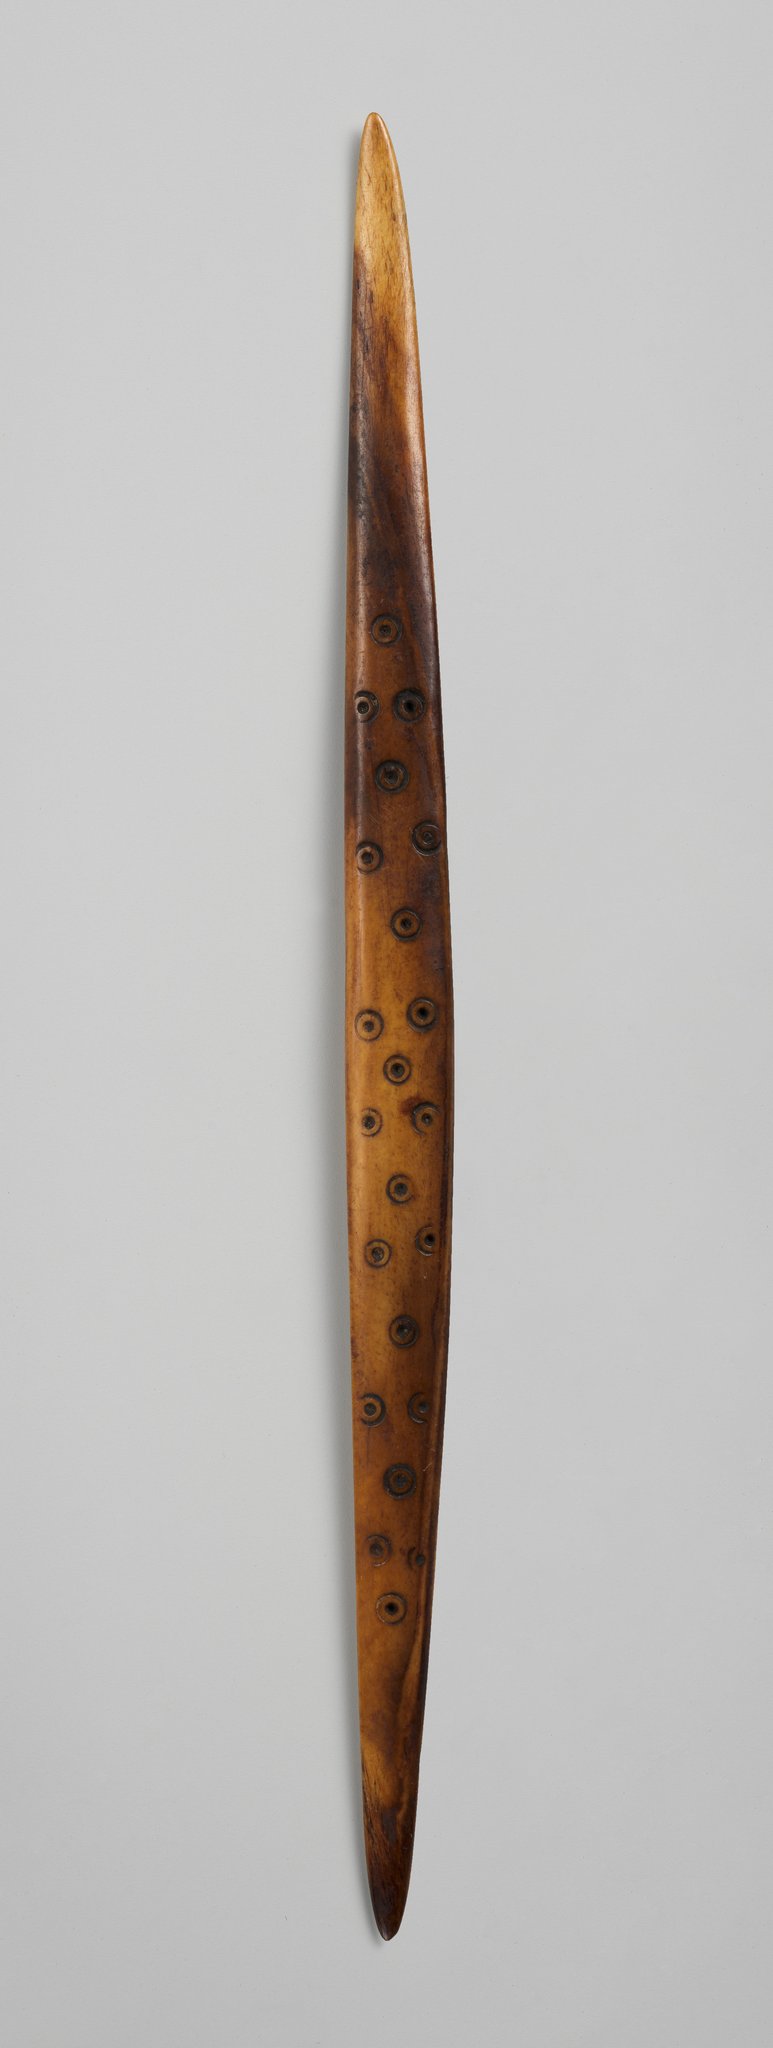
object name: weaving tool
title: Weaving Sword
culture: peruvian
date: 901-1600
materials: bone, pigment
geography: peru